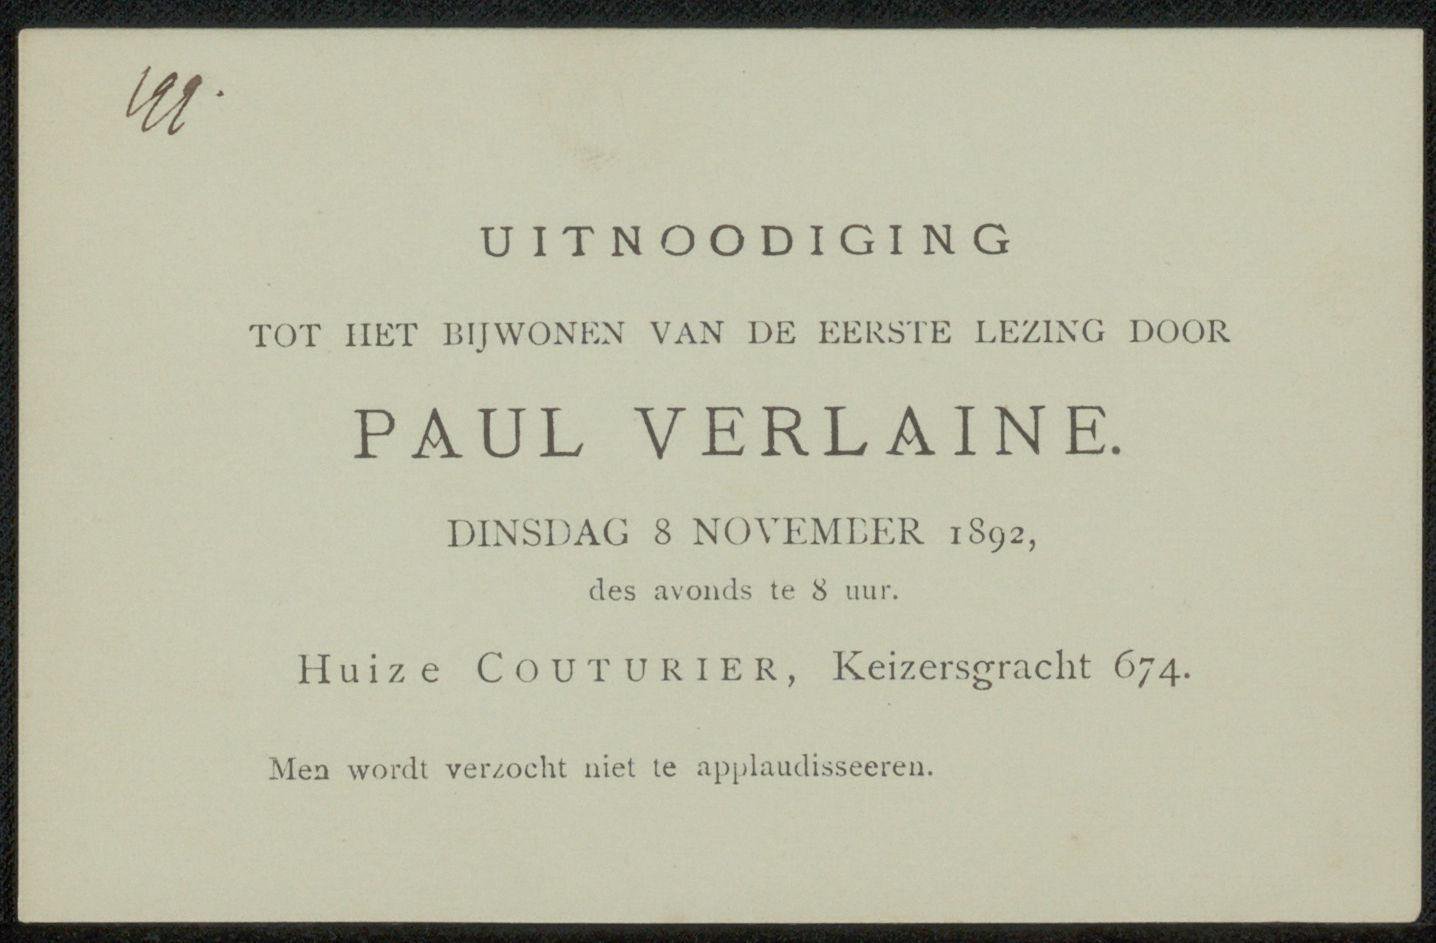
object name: invitation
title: Uitnodiging uit archief Philip Zilcken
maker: Anonymous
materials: cardboard, ink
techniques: pen, printing, writing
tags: paris, paul verlaine, painter, draughtsman, philip zilcken, amsterdam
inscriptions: collector's mark: ‘RPK’